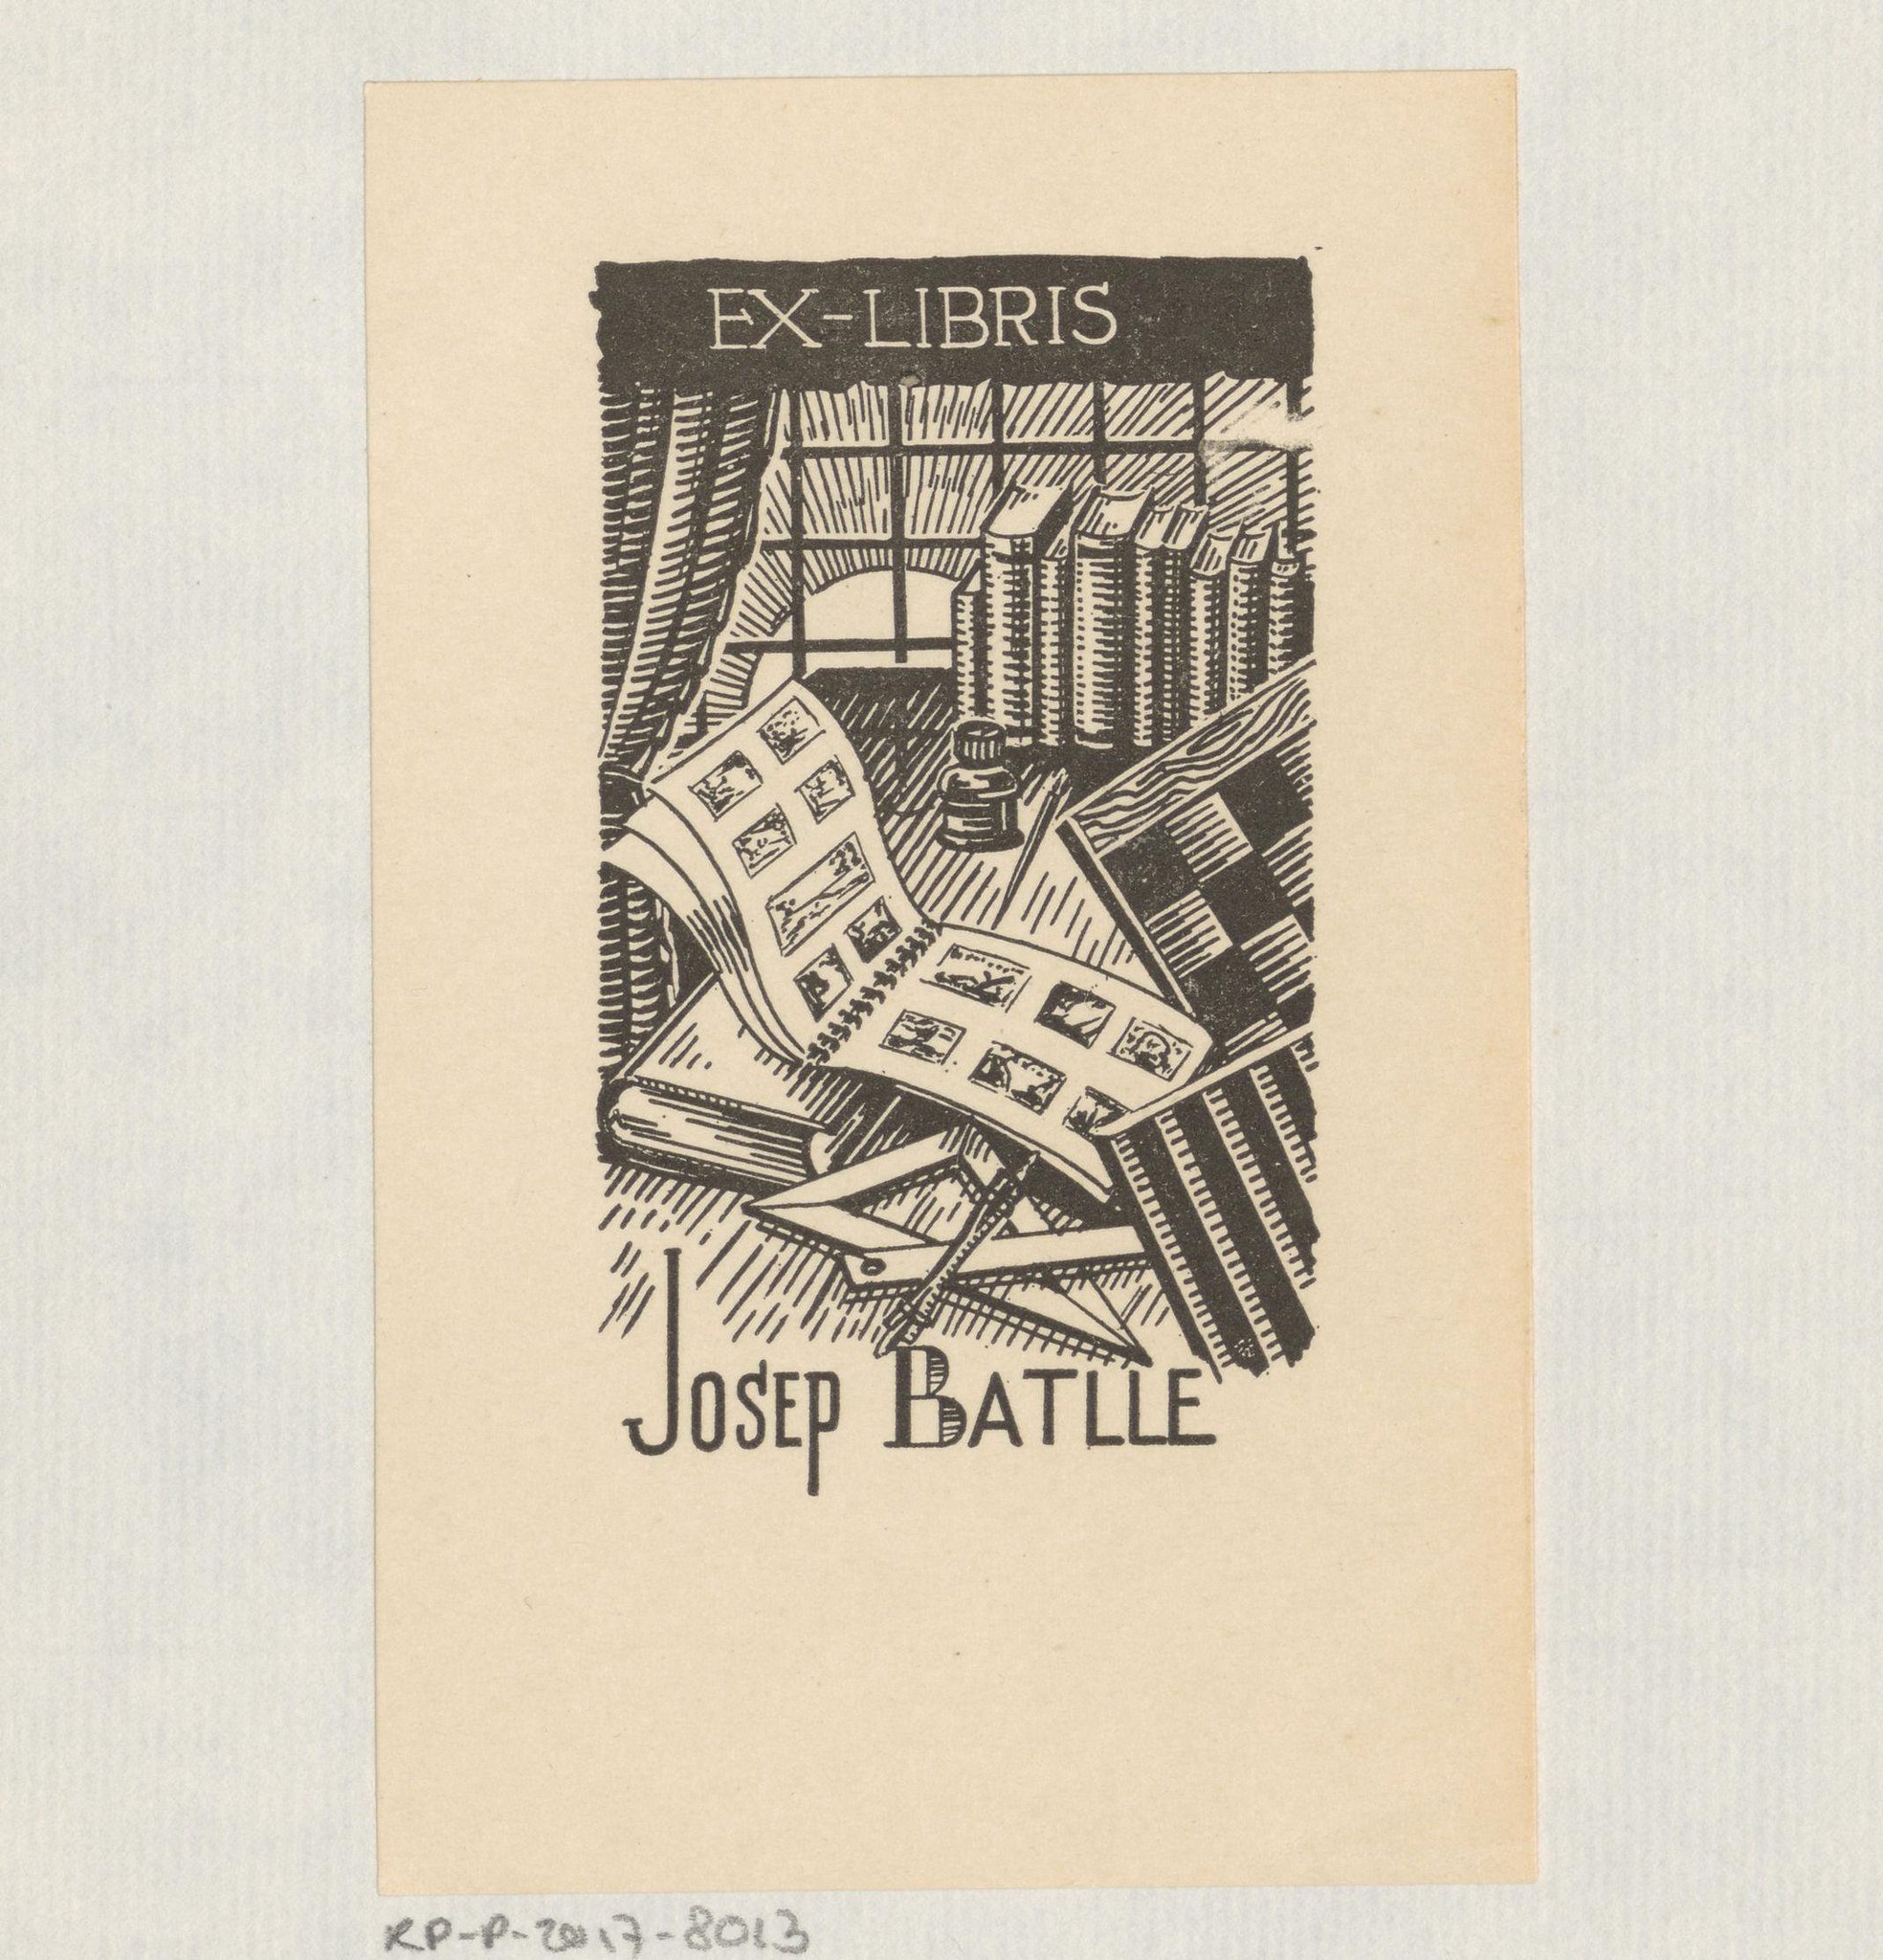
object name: bookplate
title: Ex libris van Josep Batlle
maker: Anonymous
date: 1900-1949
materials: paper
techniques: printing block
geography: spain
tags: book, sun as celestial body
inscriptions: inscription: ‘Cliche = J. Jalofre [?]’